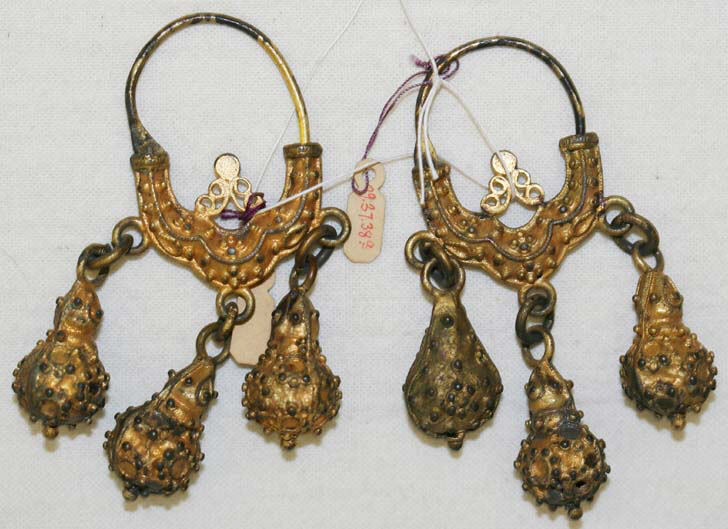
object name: earring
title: Earrings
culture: european, eastern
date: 1701-1900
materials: metal